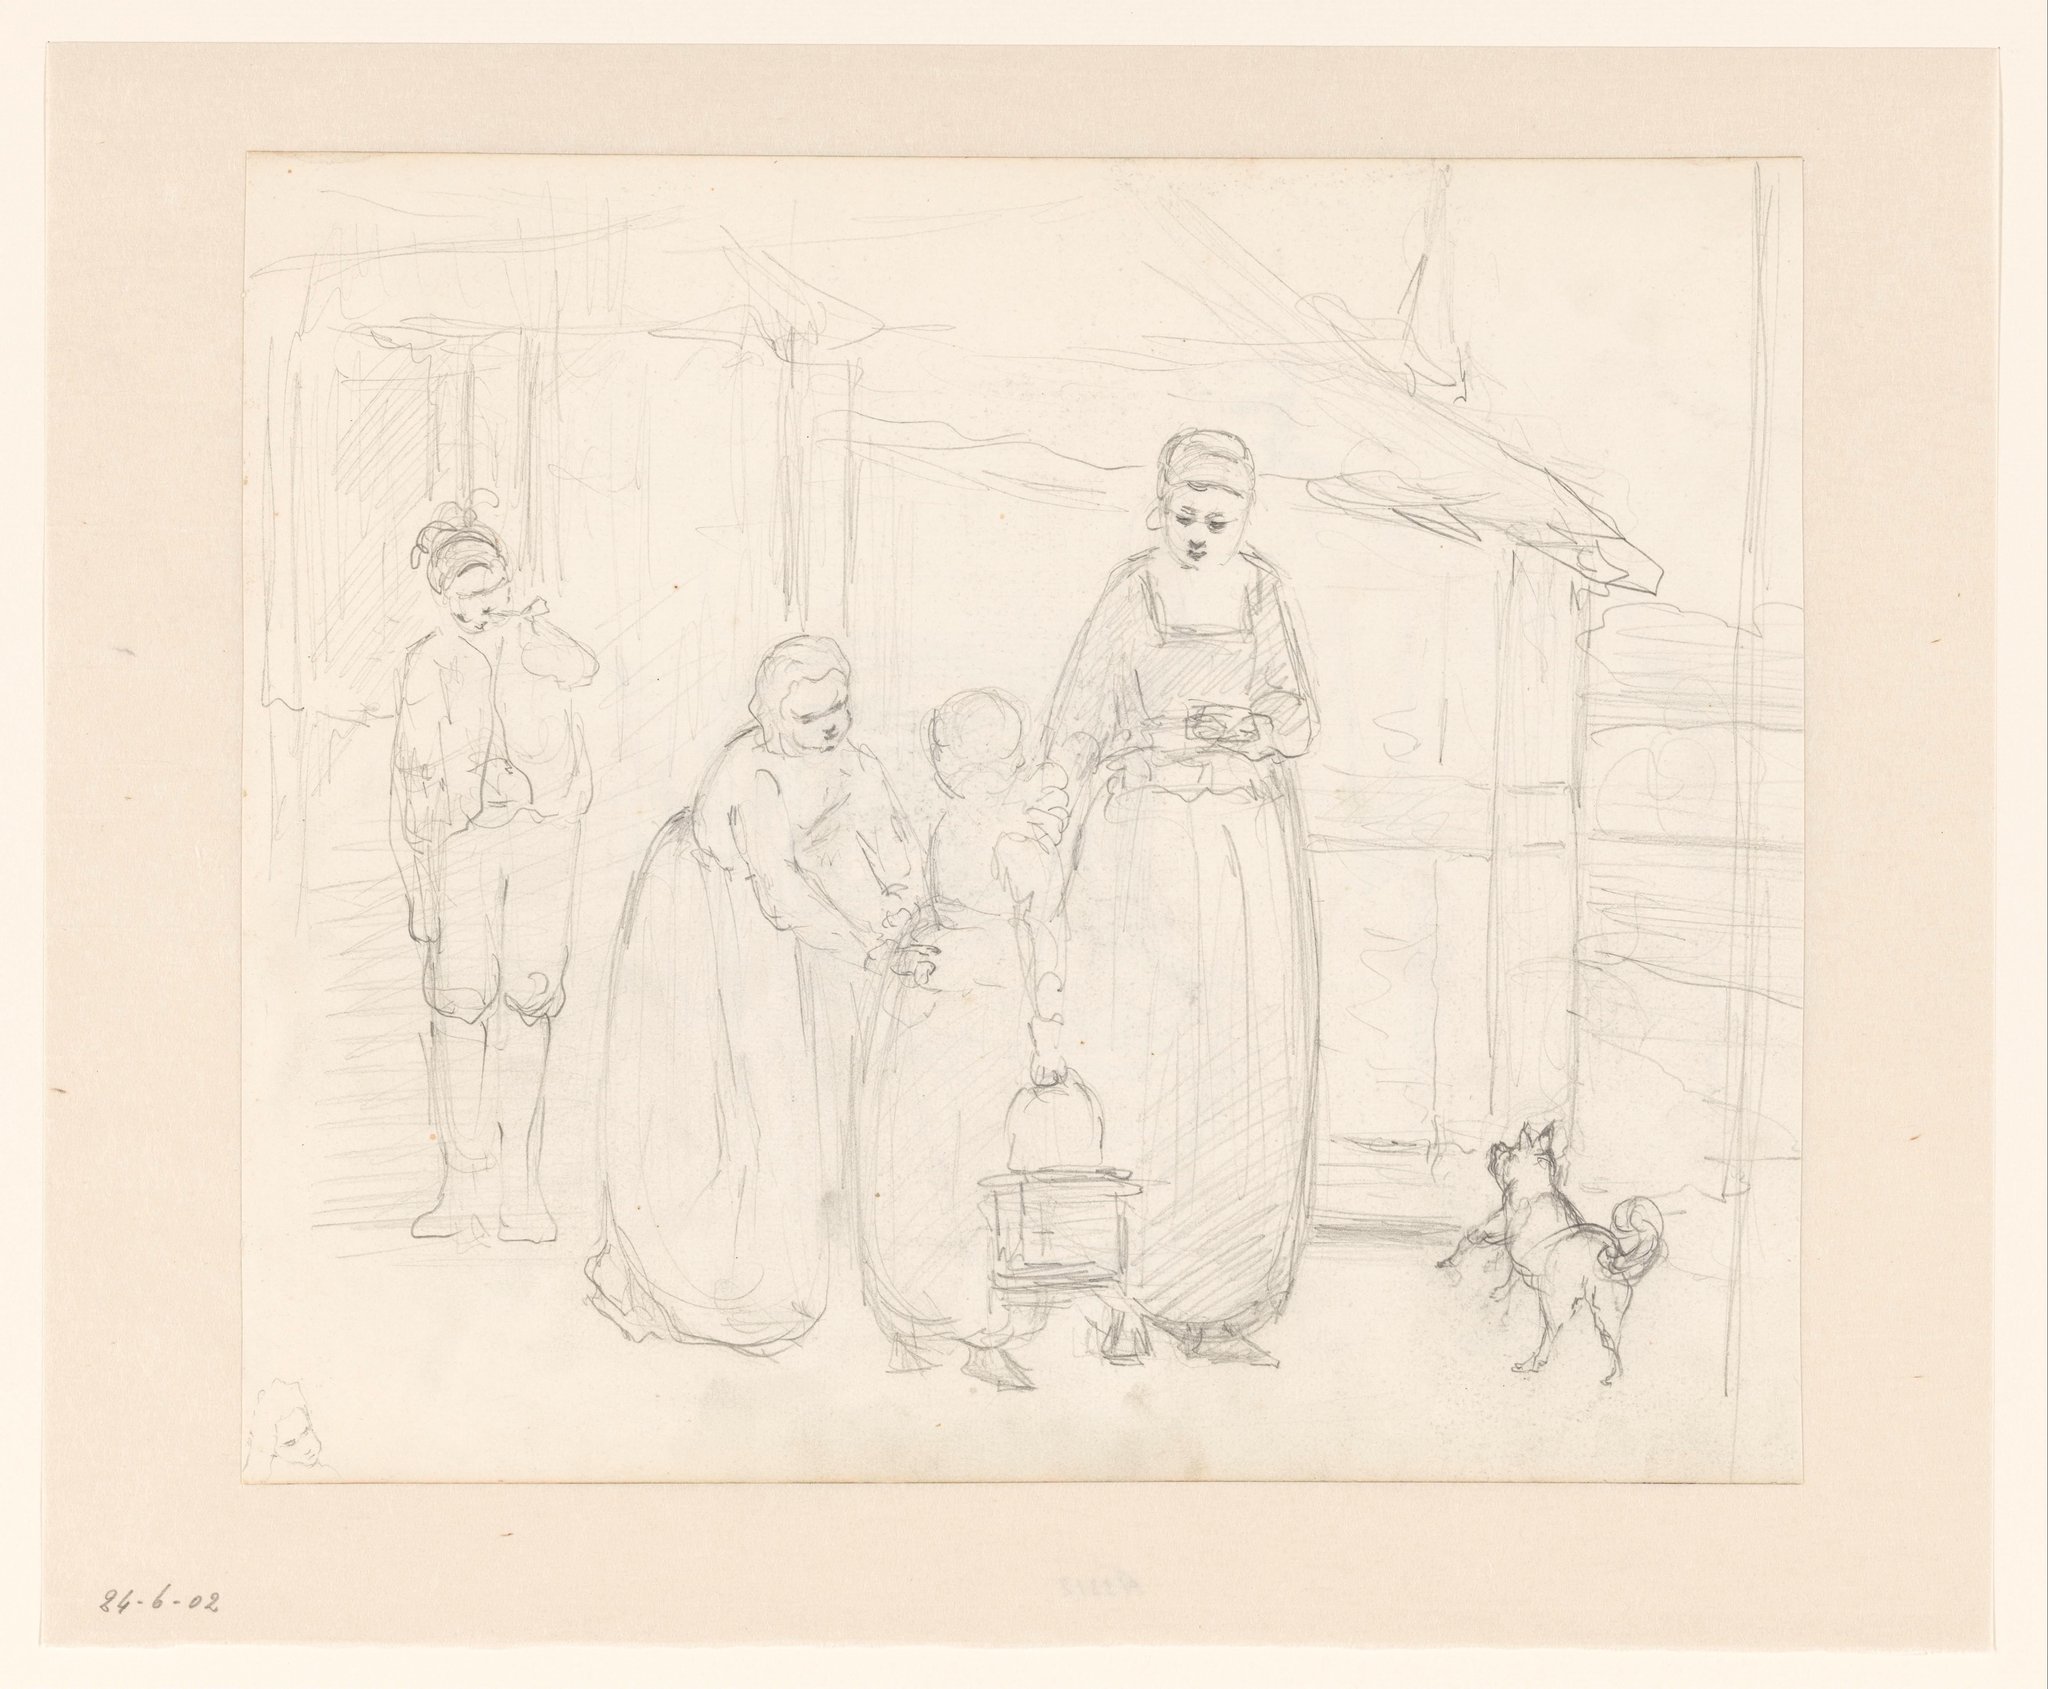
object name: drawing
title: Voorbereidselen voor den kerkgang; vrouwen en kind met stoof bij een huis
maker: hendrik valkenburg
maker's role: draughtsman, painter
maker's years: 1826-1896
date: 1836-1896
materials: paper, pencil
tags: going to church, family life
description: Voorbereidselen voor den kerkgang; vrouwen en kind met stoof bij een huis. Verso: vrouwen bij een wieg.